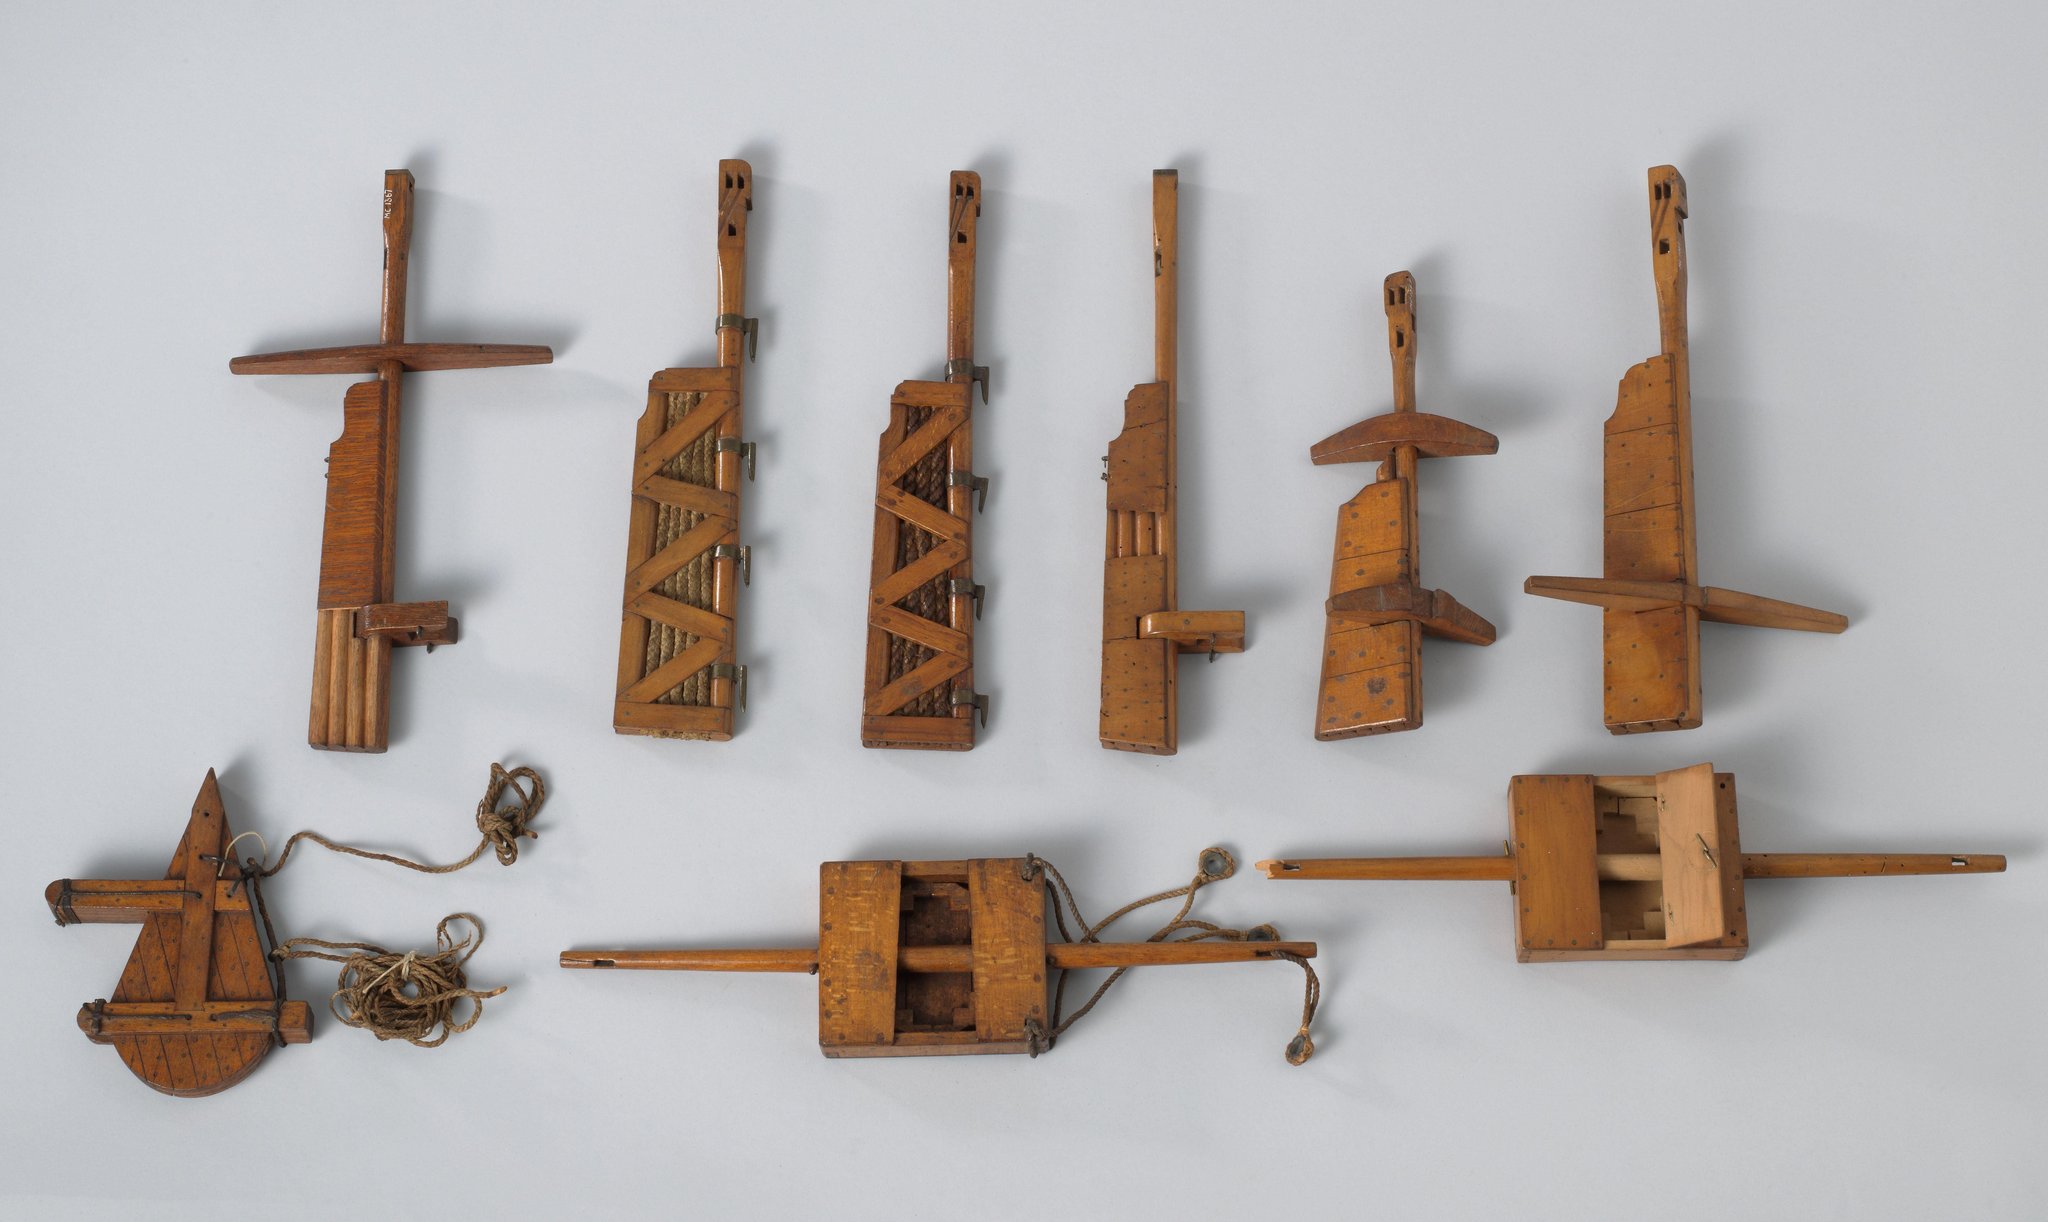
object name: demonstration model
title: Model of a Jury Rudder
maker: Anonymous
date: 1820-1870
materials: fiber, wood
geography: netherlands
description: Negen modellen van noodroeren. Drie noodroeren (nrs. 1-3) zijn bijna identiek aan de modellen NG-MC-228, 229 en 230. Ze hebben een steng als roerkoning en het roerblad is samengesteld uit rondhouten met planken bedekt. Twee daarvan (nrs. 1-2) hebben een ezelshoofd als roerhaak om de koning, bij de derde is hiervoor een ankerstok gebruikt. Eén noodroer (nr. 2) heeft een ankerstok om de roerkop, vergelijkbaar met model NG-MC-229 (Pakenhams noodroer). Het vierde model is een kleinere versie van dit type noodroer en heeft twee korte ankerstokken om de koning, een als roerhaak en een om de roerkop. Twee bijna identieke modellen (nrs. 5-6) zijn noodroeren met een steng als roerkoning en het roerblad is samengesteld uit trossen die door planken bijeen worden gehouden; deze modellen hebben speciale messing roerhaken. Het zevende model, van planken gemaakt, heeft een druppelvorm en is vermoedelijk gebaseerd op het ontwerp van Bassiere. Het laatste paar modellen (nrs. 8-9) bestaat uit een ra waar een kast omheen is gebouwd. De hoeken van de kast zijn aan de binnenkant verstevigd met de wangen van rolpaarden. Eén model (nr. 8) is voorzien van stroppen aan één kant, vermoedelijk voor de bevestiging van stuurtalies.